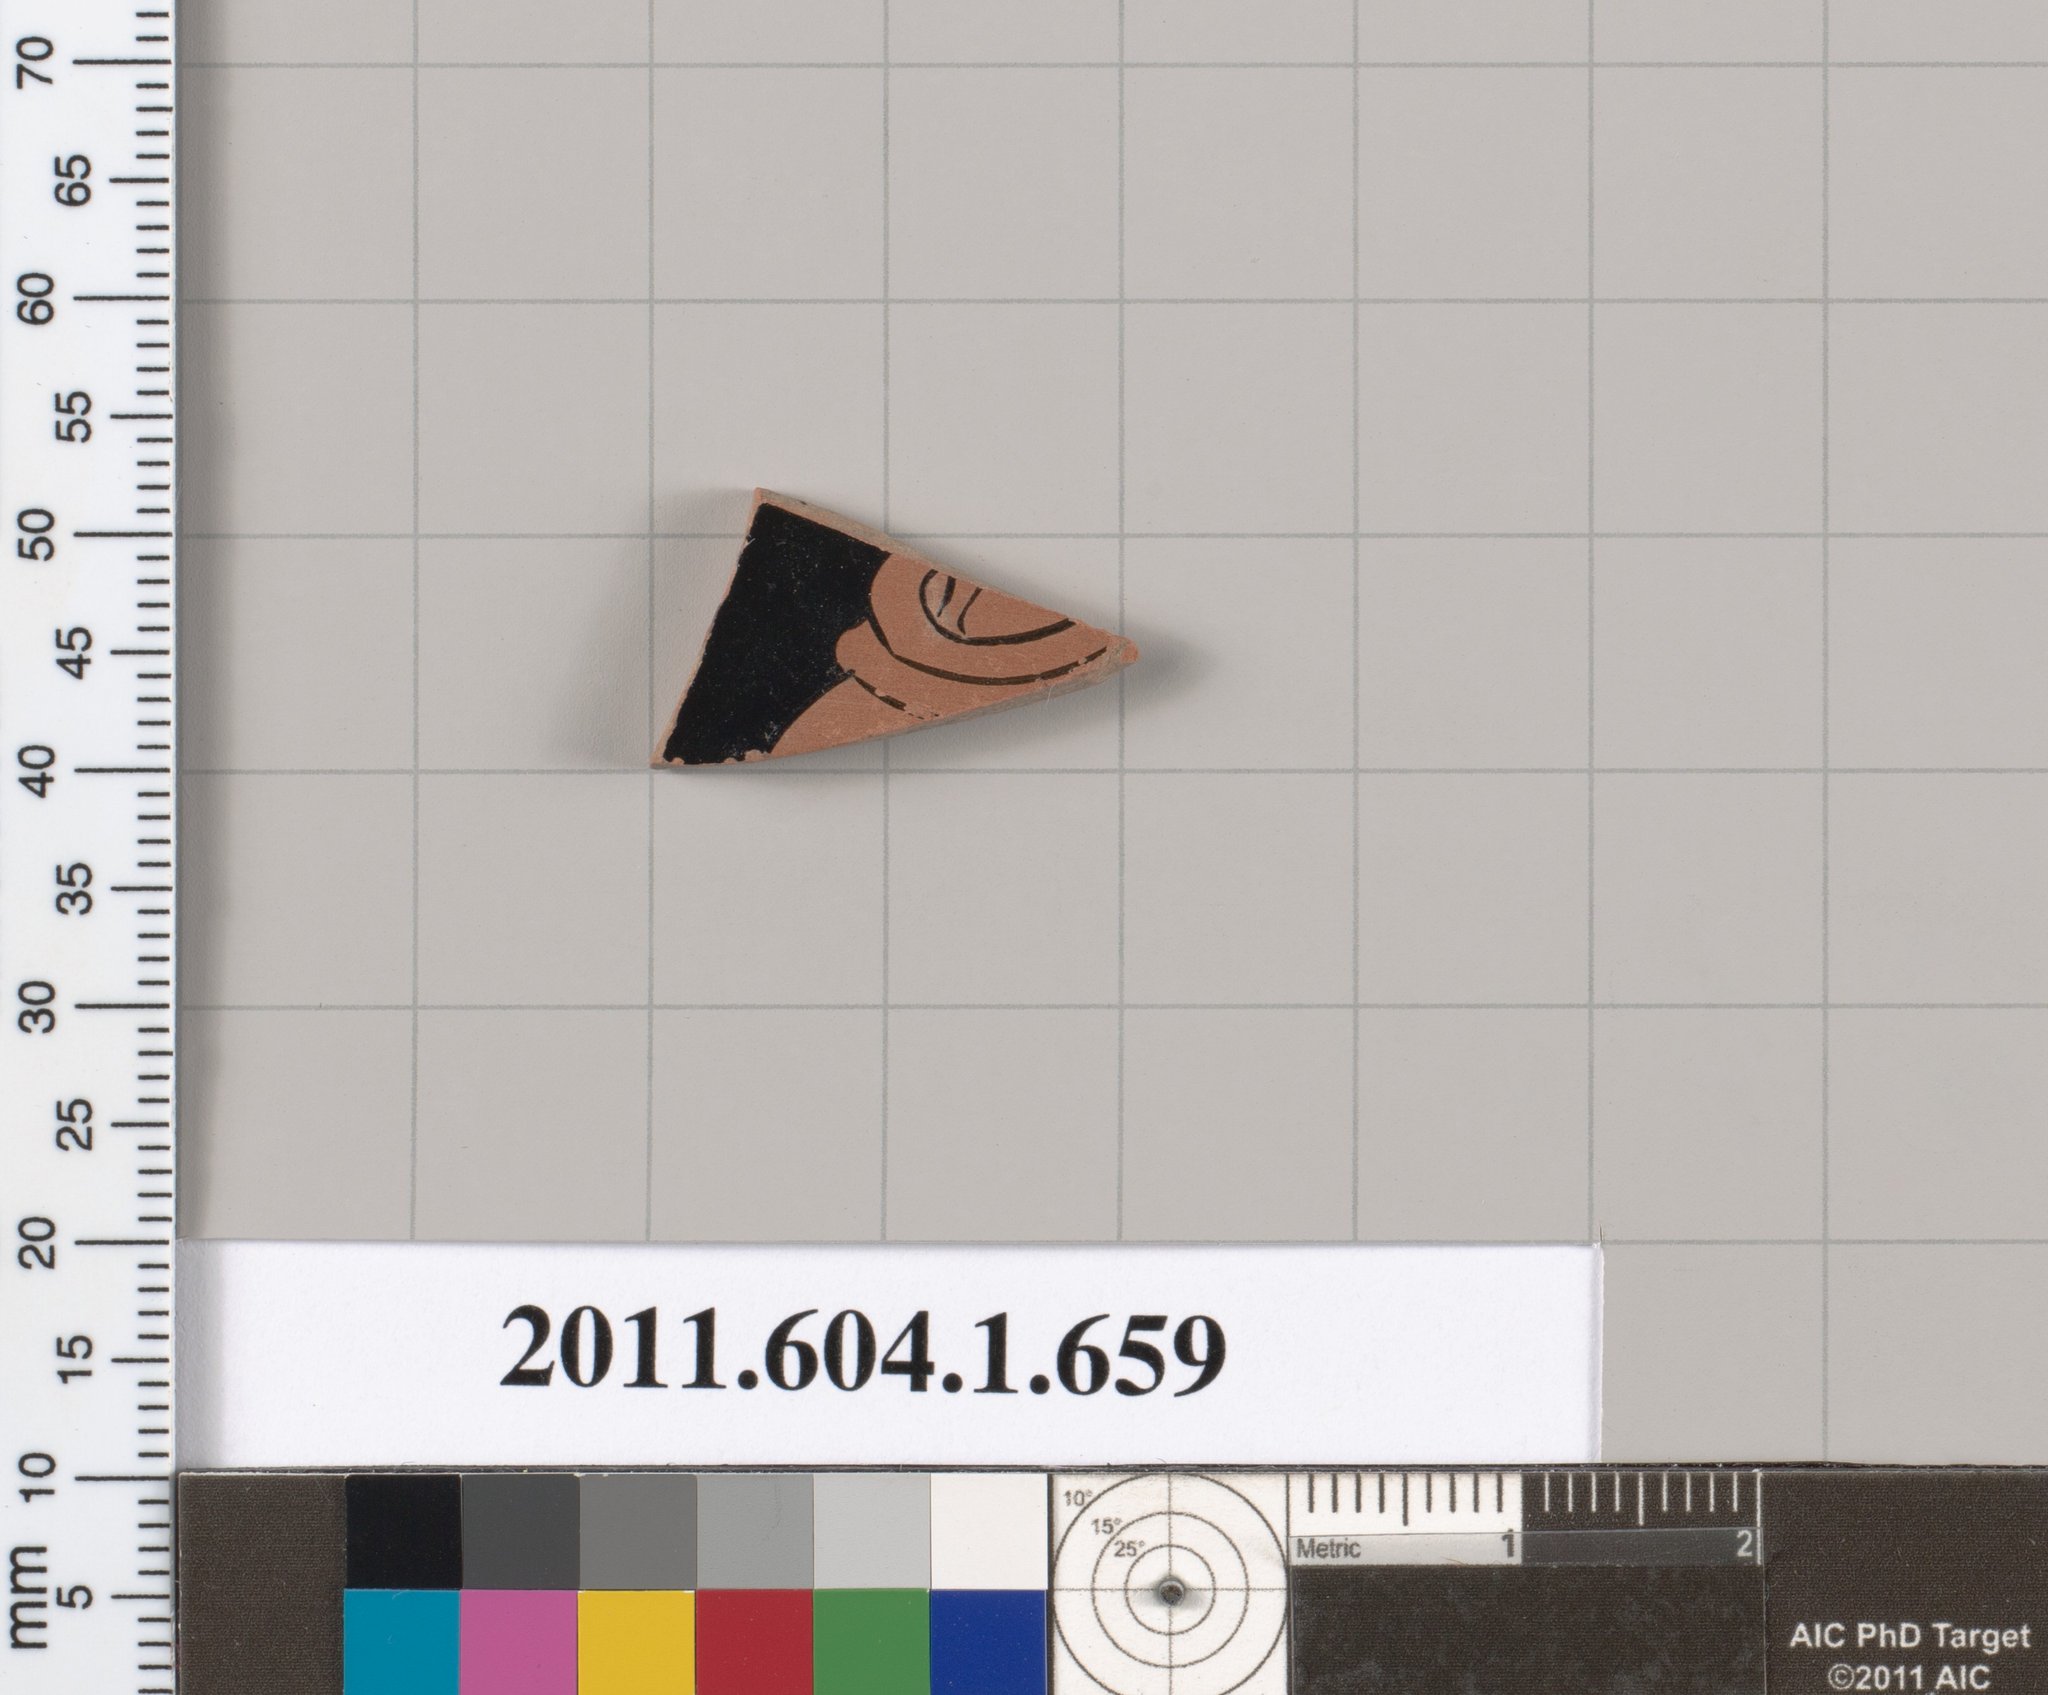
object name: kylix fragment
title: Terracotta fragment of a kylix (drinking cup)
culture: greek, attic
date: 475-451 BCE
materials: terracotta